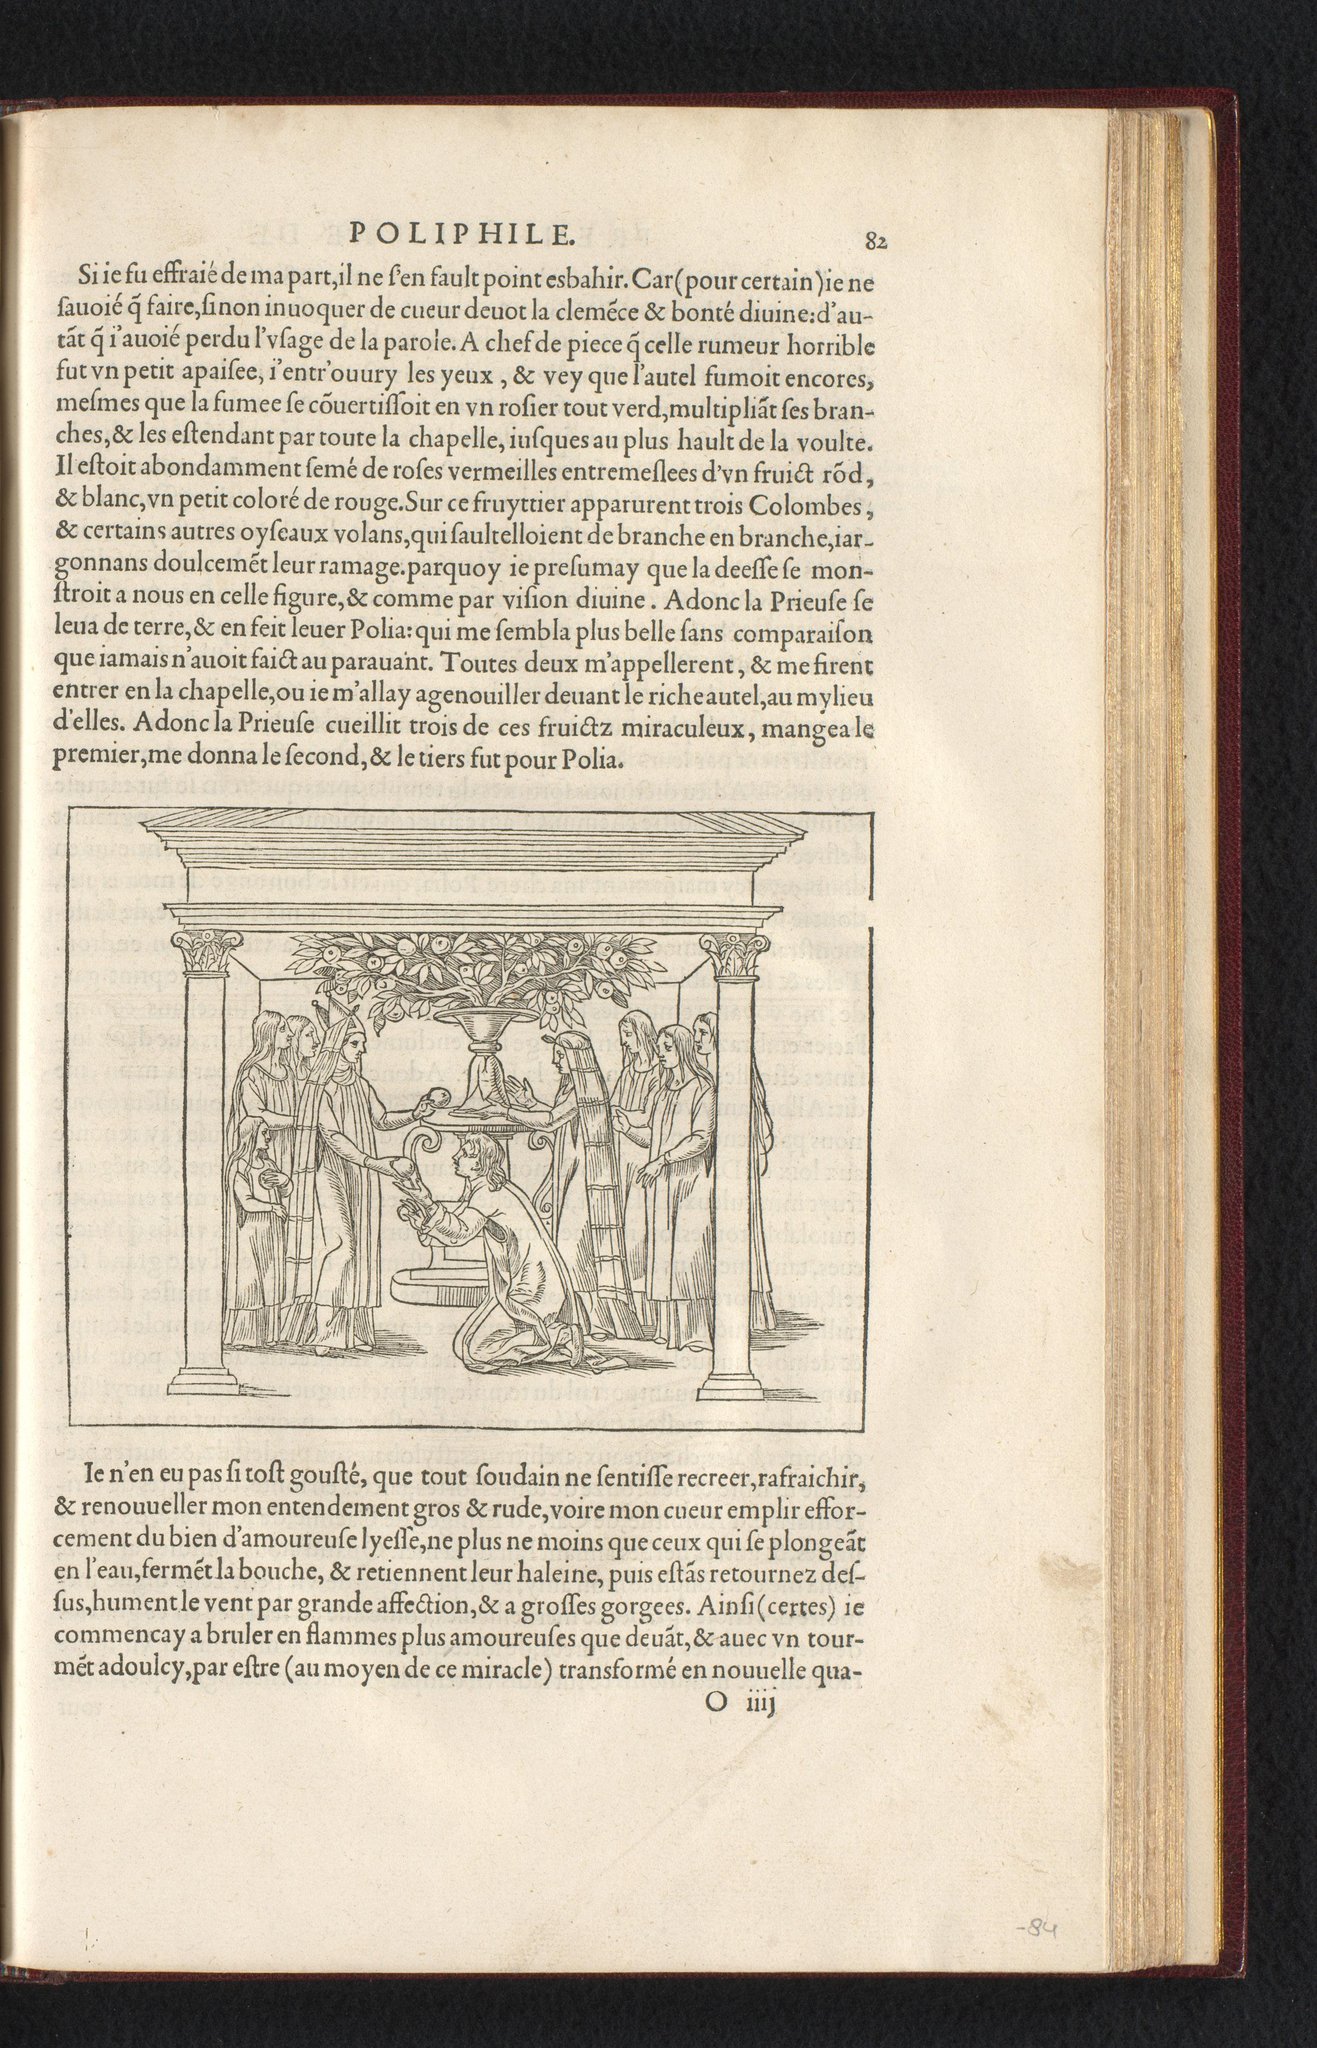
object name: print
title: Priesteres geeft Polia en Poliphilo fruit uit de boom die in het altaar groeide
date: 1546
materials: paper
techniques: letterpress printing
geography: paris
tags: altar ~ non-christian religions, priest ~ greek religion - ee - priestess, (scenes from) specific works of literature: colonna, hypnerotomachia poliphili, picking fruit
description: Prent uit: Colonna, Francesco. Hypnerotomachie ou discours du songe de Poliphile, deduisant comme amour le combat a l'occasion de Polia. Parijs: Jacques Kerver, 1546, recto fol. 82.